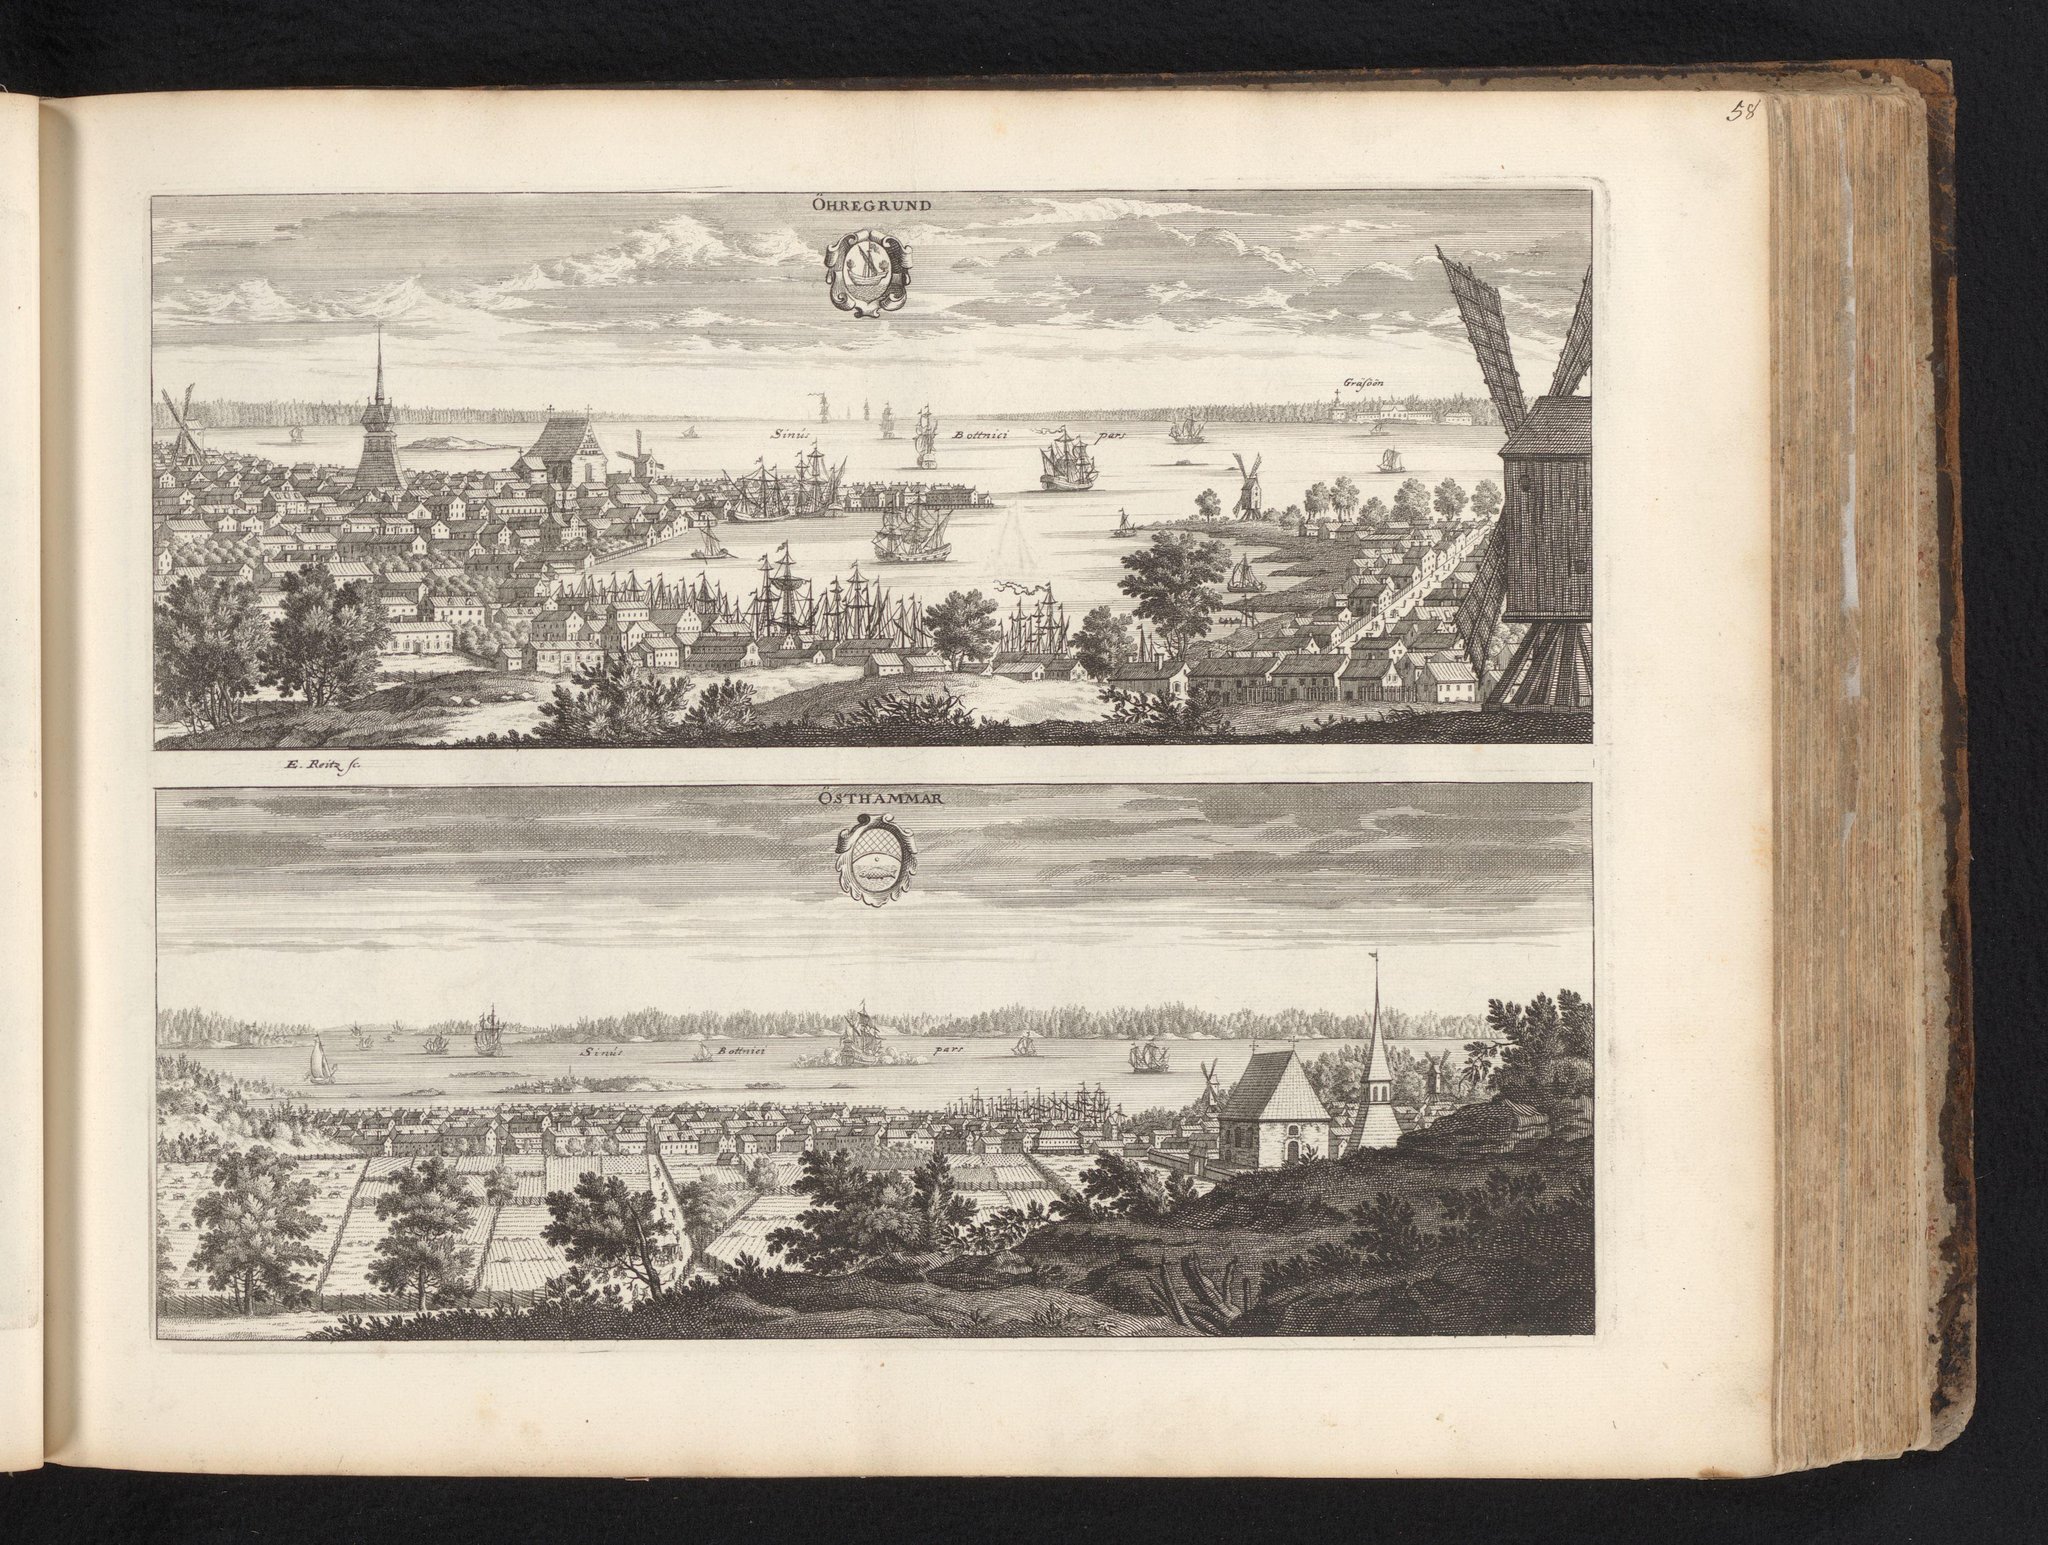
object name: print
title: Gezicht op Öregrund en Östhammar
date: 1695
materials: paper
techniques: etching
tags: city-view in general; 'veduta'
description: Kungliga Biblioteket, 'Suecia': http://www.kb.se/samlingarna/Kartor-bilder/Suecia-antiqua/ (geraadpleegd november 2016).